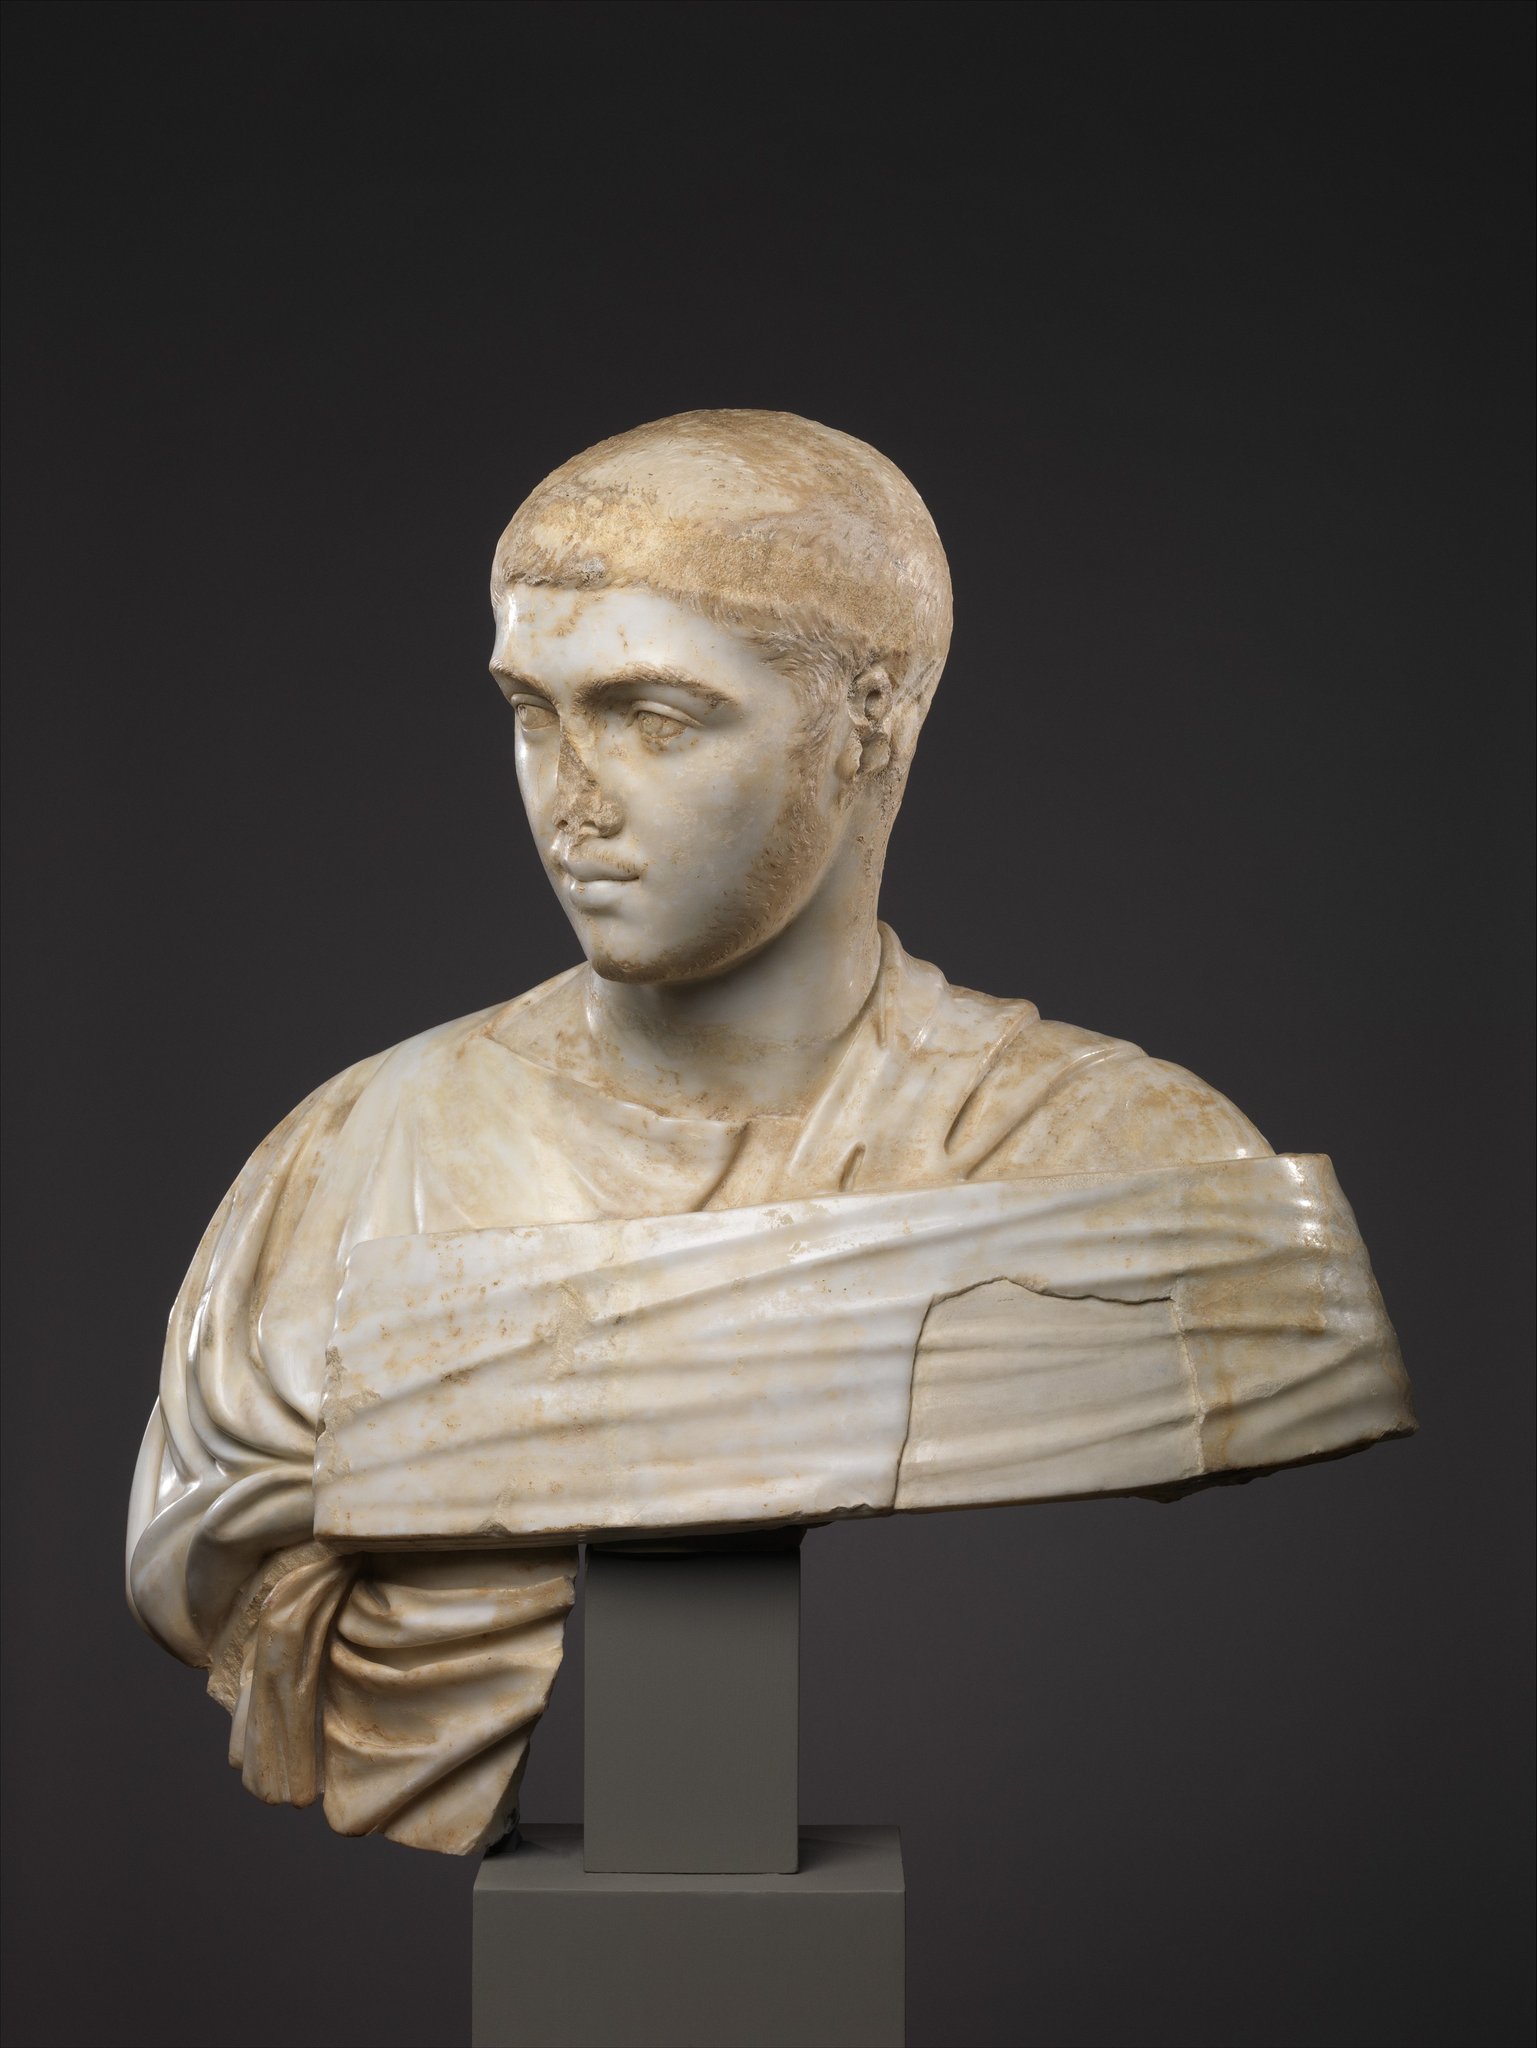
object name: portrait bust of severus alexander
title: Marble portrait bust of Severus Alexander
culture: roman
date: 230-235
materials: marble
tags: men,portraits